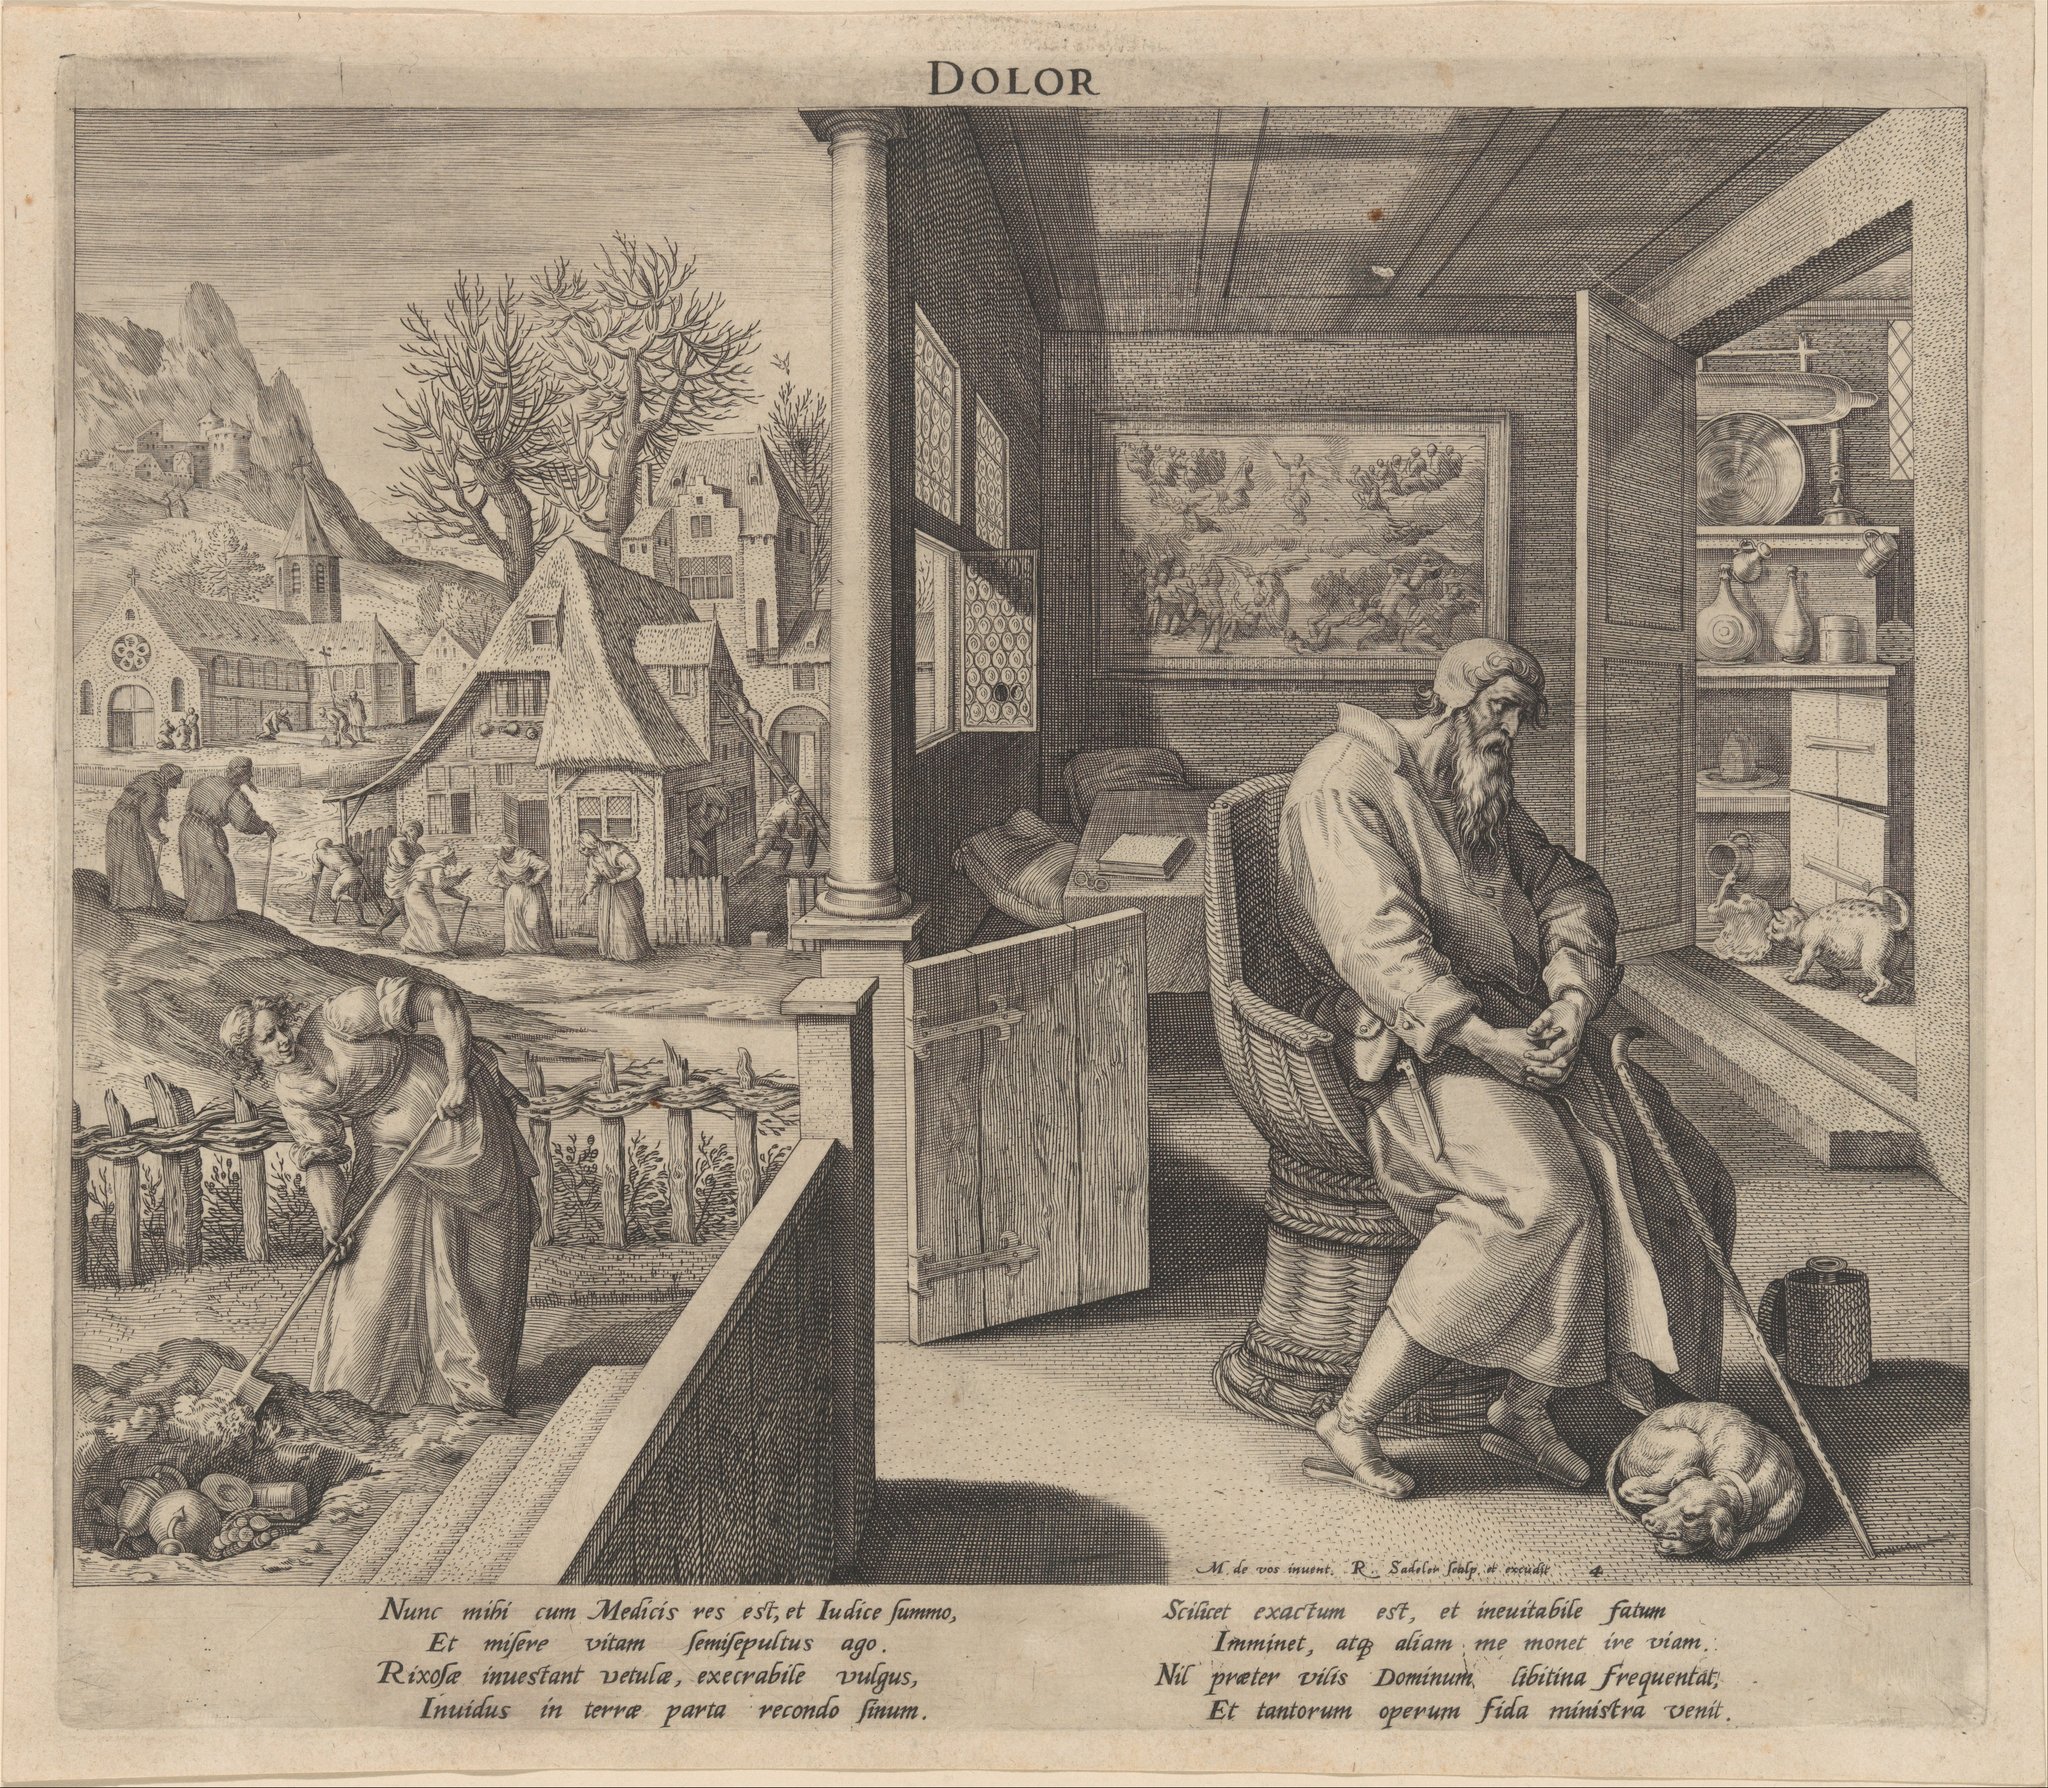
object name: print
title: Dolor (Sorrow)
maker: raphael sadeler i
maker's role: artist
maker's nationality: netherlandish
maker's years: 1560-1628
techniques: engraving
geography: netherlands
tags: buildings,men,women,dogs,working